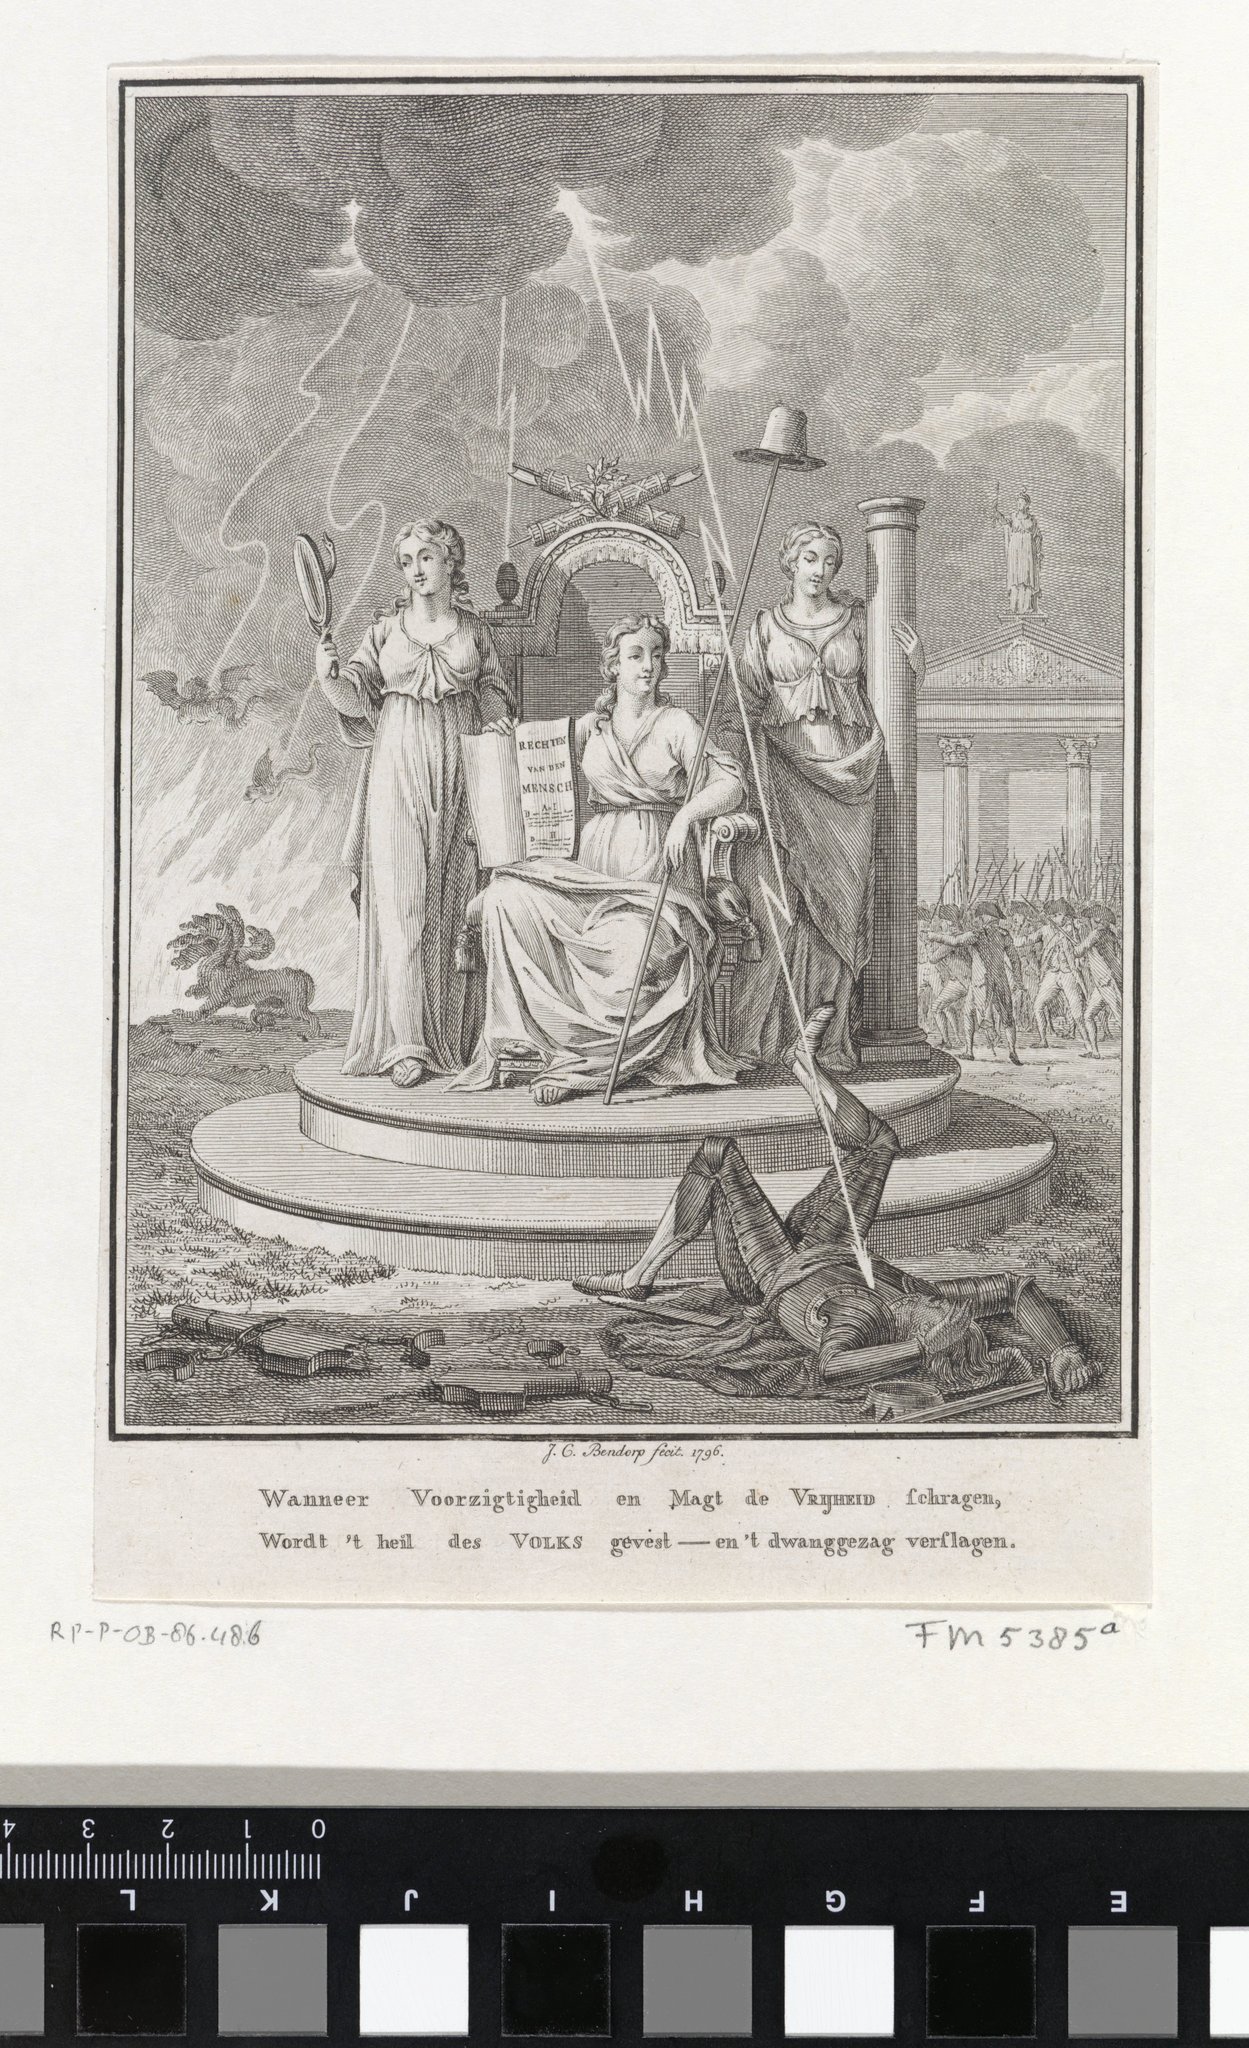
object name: print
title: Allegorie op de Vrijheid, 1795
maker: johannes christiaan bendorp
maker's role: print maker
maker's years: 1766-1849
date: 1796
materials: paper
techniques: engraving, etching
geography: netherlands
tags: fortitude, 'fortitudo' ~ one of the four cardinal virtues, prudence, 'prudentia'; 'prudenza' (ripa) ~ one of the four cardinal virtues, freedom, liberty; 'libertà' (ripa) (+ abstract concept represented by female figure)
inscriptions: collector's mark: Lugt 2228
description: Allegorie op de Vrijheid en de Rechten van de Mens, 1795. Vrijheid zittend op troon geflankeerd door Voorzichtigheid en Kracht. Op de voorgrond de verslagen Heerszucht, op de achtergrond het volk voor een tempel. Met tweeregelig vers.